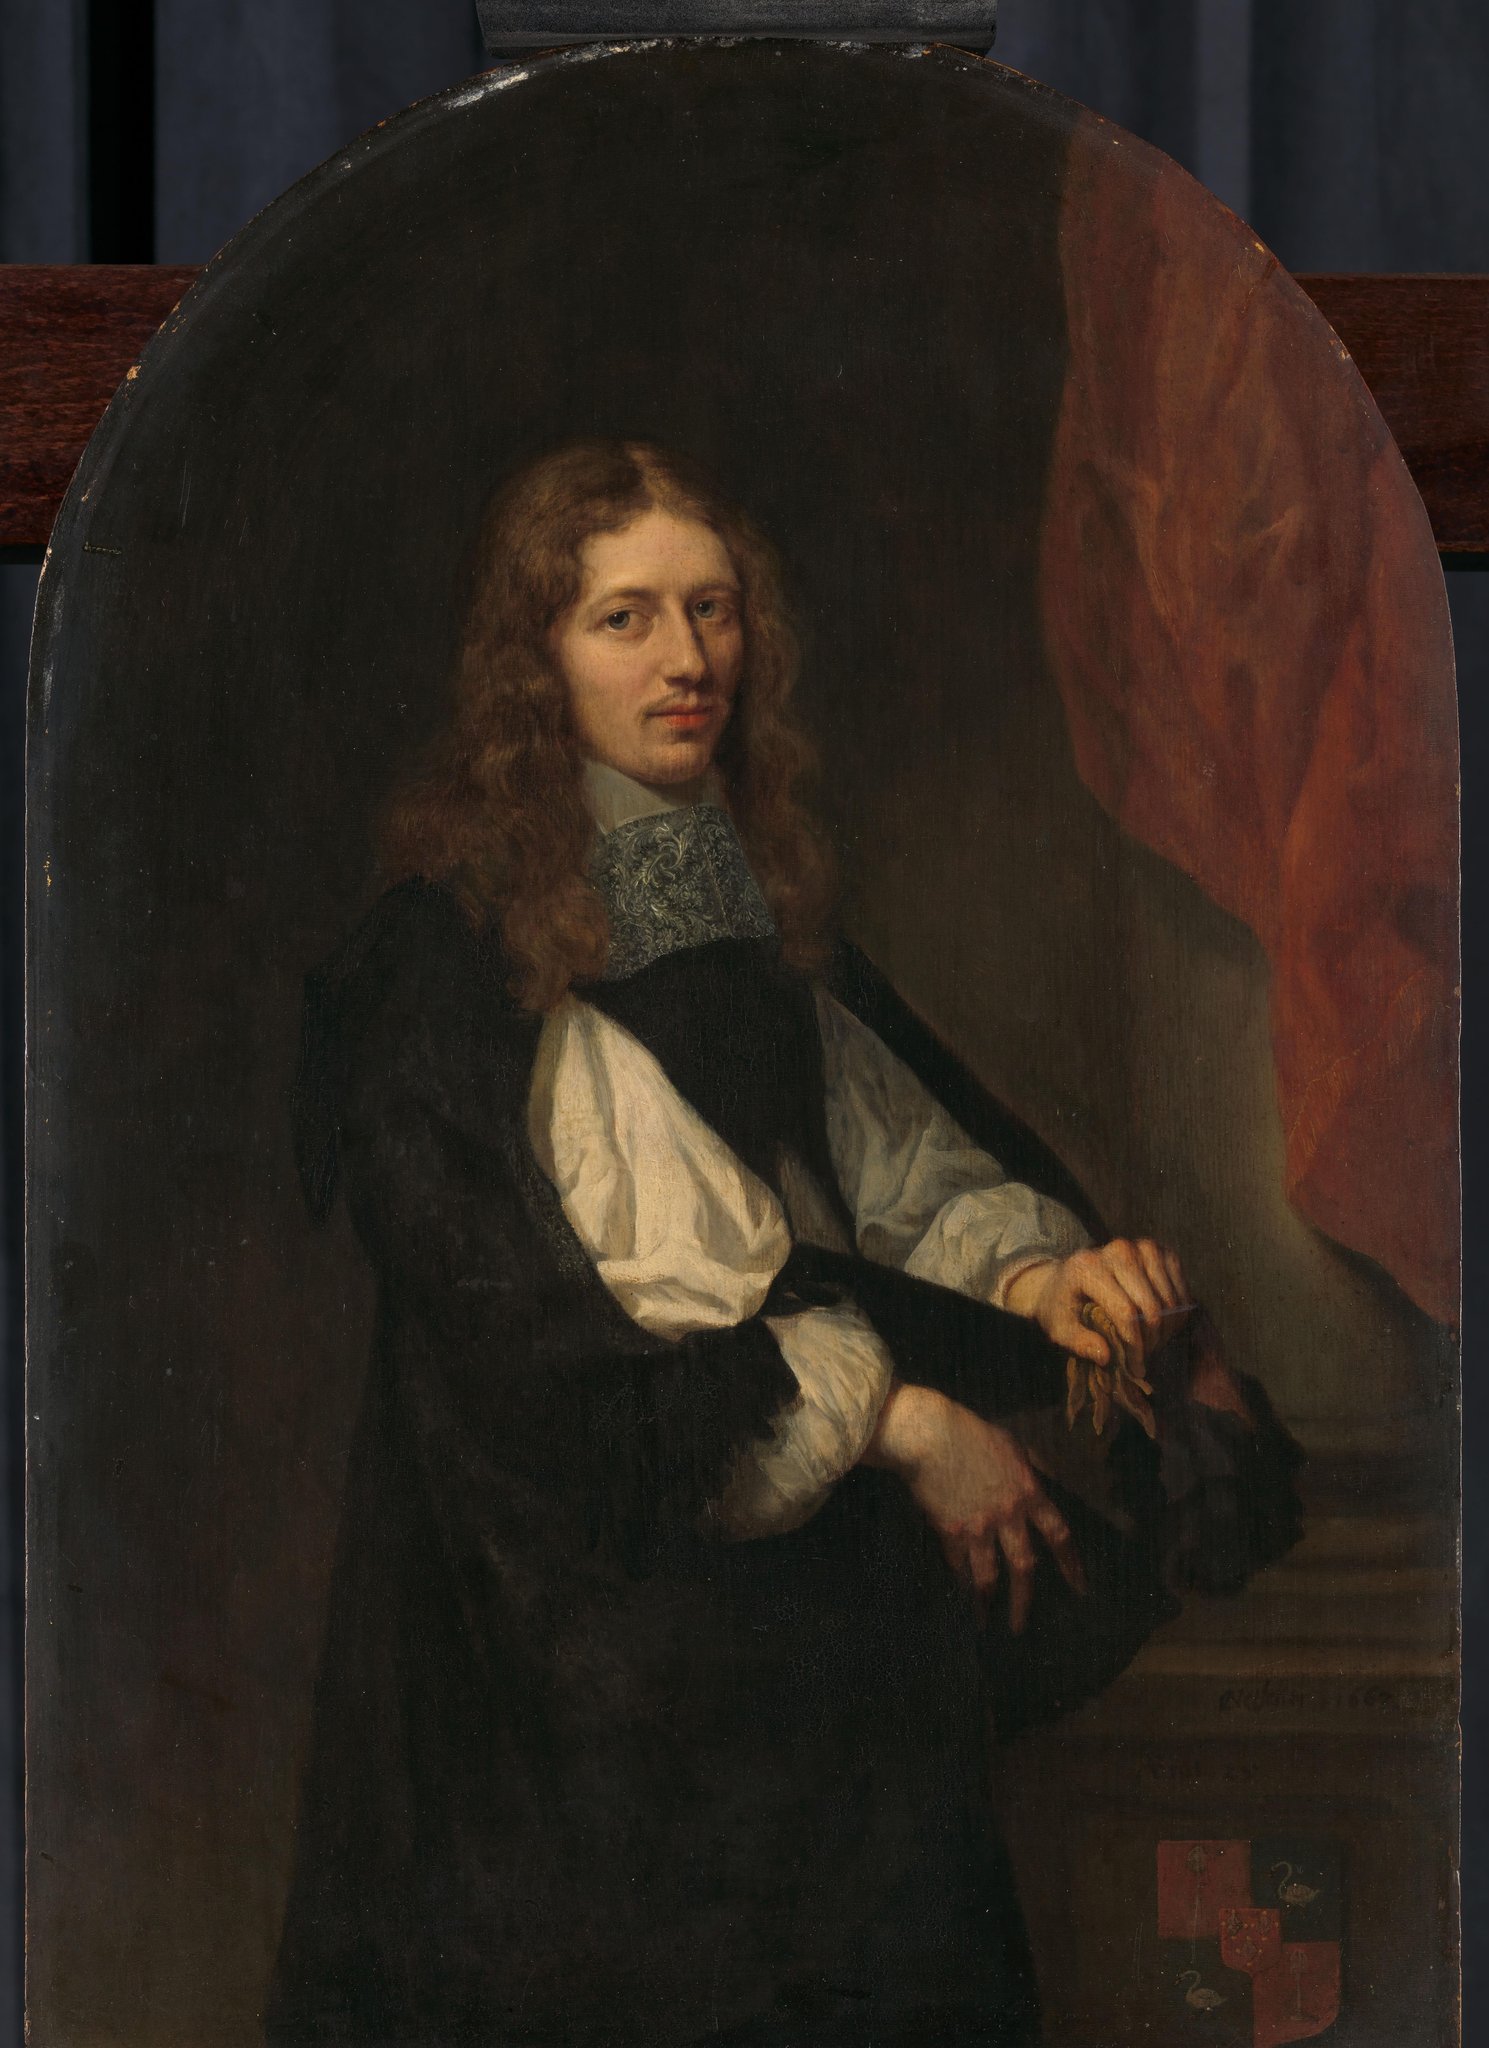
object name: painting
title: Portrait of Pieter de Graeff (1638-1707), lord of Zuid-Polsbroek, Purmerland, and Ilpendam. Alderman of Amsterdam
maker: caspar netscher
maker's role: draughtsman, painter, print maker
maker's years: 1639-1684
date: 1663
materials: oil, panel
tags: amsterdam, politician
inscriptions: signature and date: ‘CNetscher 1663. AEtat 25’, coat of arms, bottom right: ‘Gevierendeeld: I en IV in rood een omgekeerde zilveren schop, II en III in blauw een zilveren zwaan. Hartschild:?’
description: Portret van Pieter de Graeff, heer van Zuid-Polsbroek, Purmerland en Ilpendam. Schepen van Amsterdam. Kniestuk, staande bij een zuil waarop het familiewapen staat. In de handen een hoed en handschoenen. Pendant van SK-A-3978.